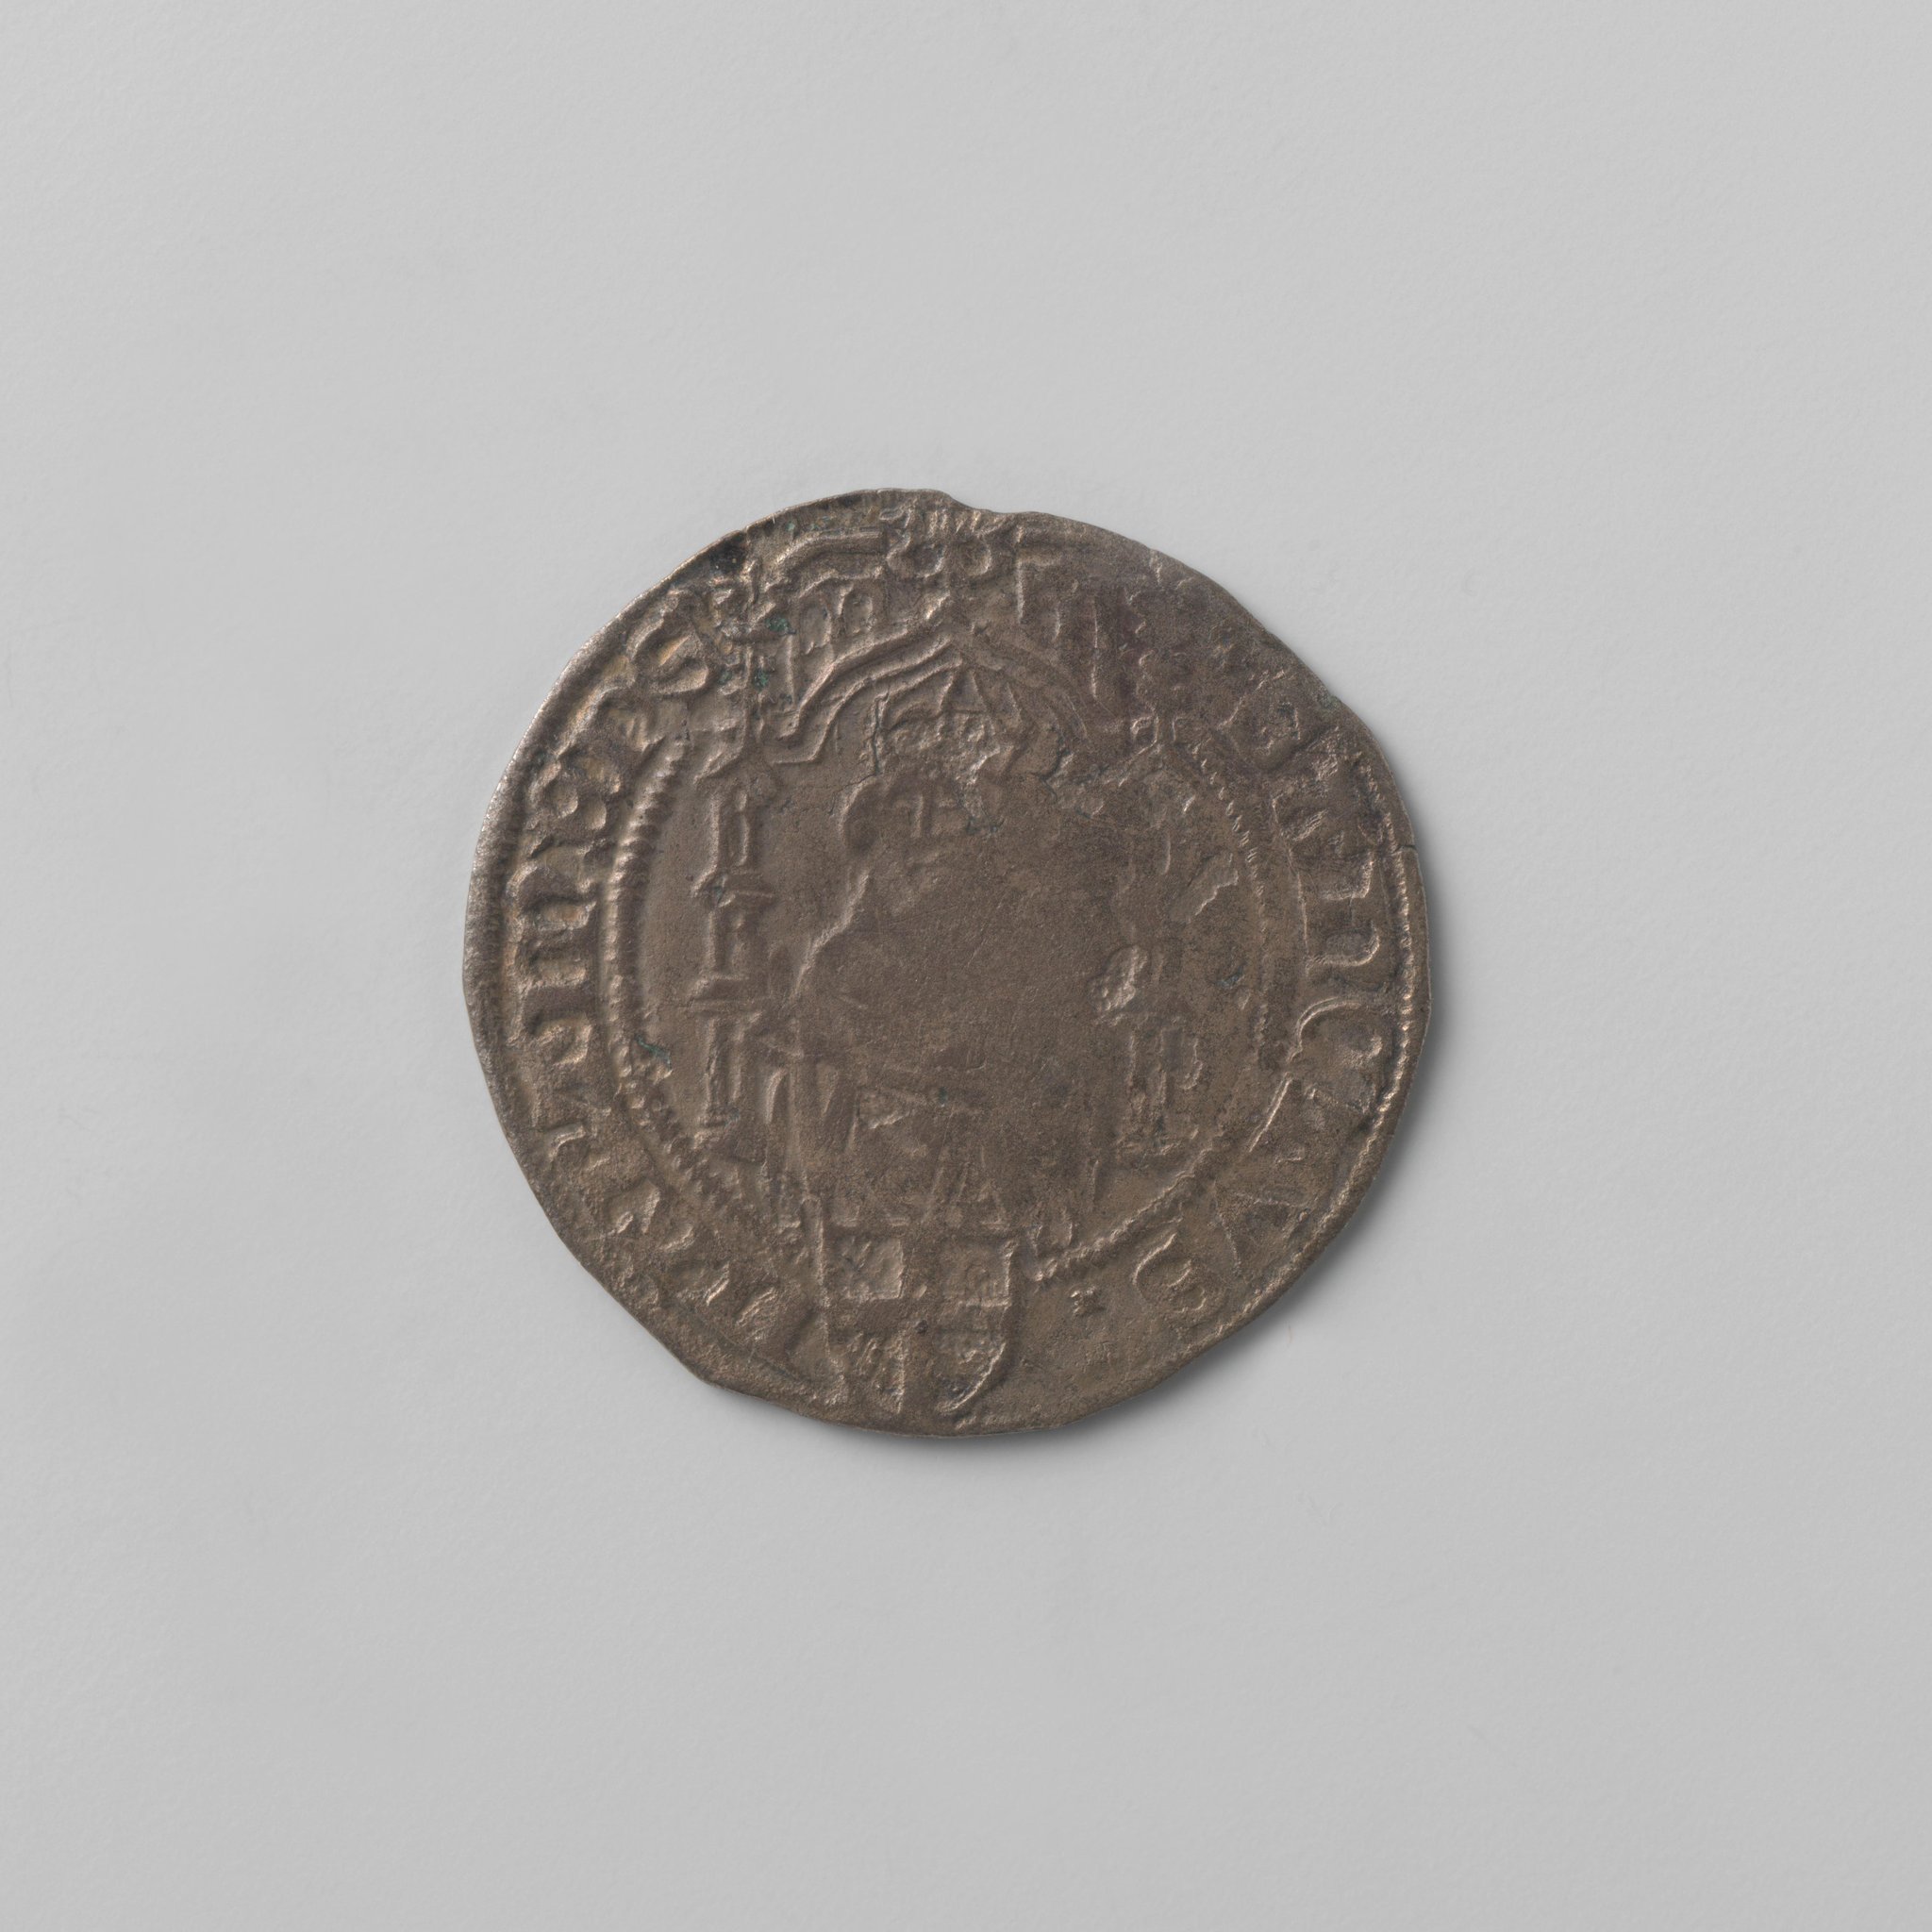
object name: coin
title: Utrechtse philippus van David van Bourgondië, 1455-1496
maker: bisschop van utrecht david van bourgondië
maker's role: bisschop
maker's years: 1427-1496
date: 1455-1496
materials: silver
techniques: striking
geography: wijk bij duurstede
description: Zilveren munt. Voorzijde: in een zetel de heilige Maarten met voor zich wapenschild van Utrecht. Keerzijde: wapenschild van David van Bourgondië, waarboven sterretje.